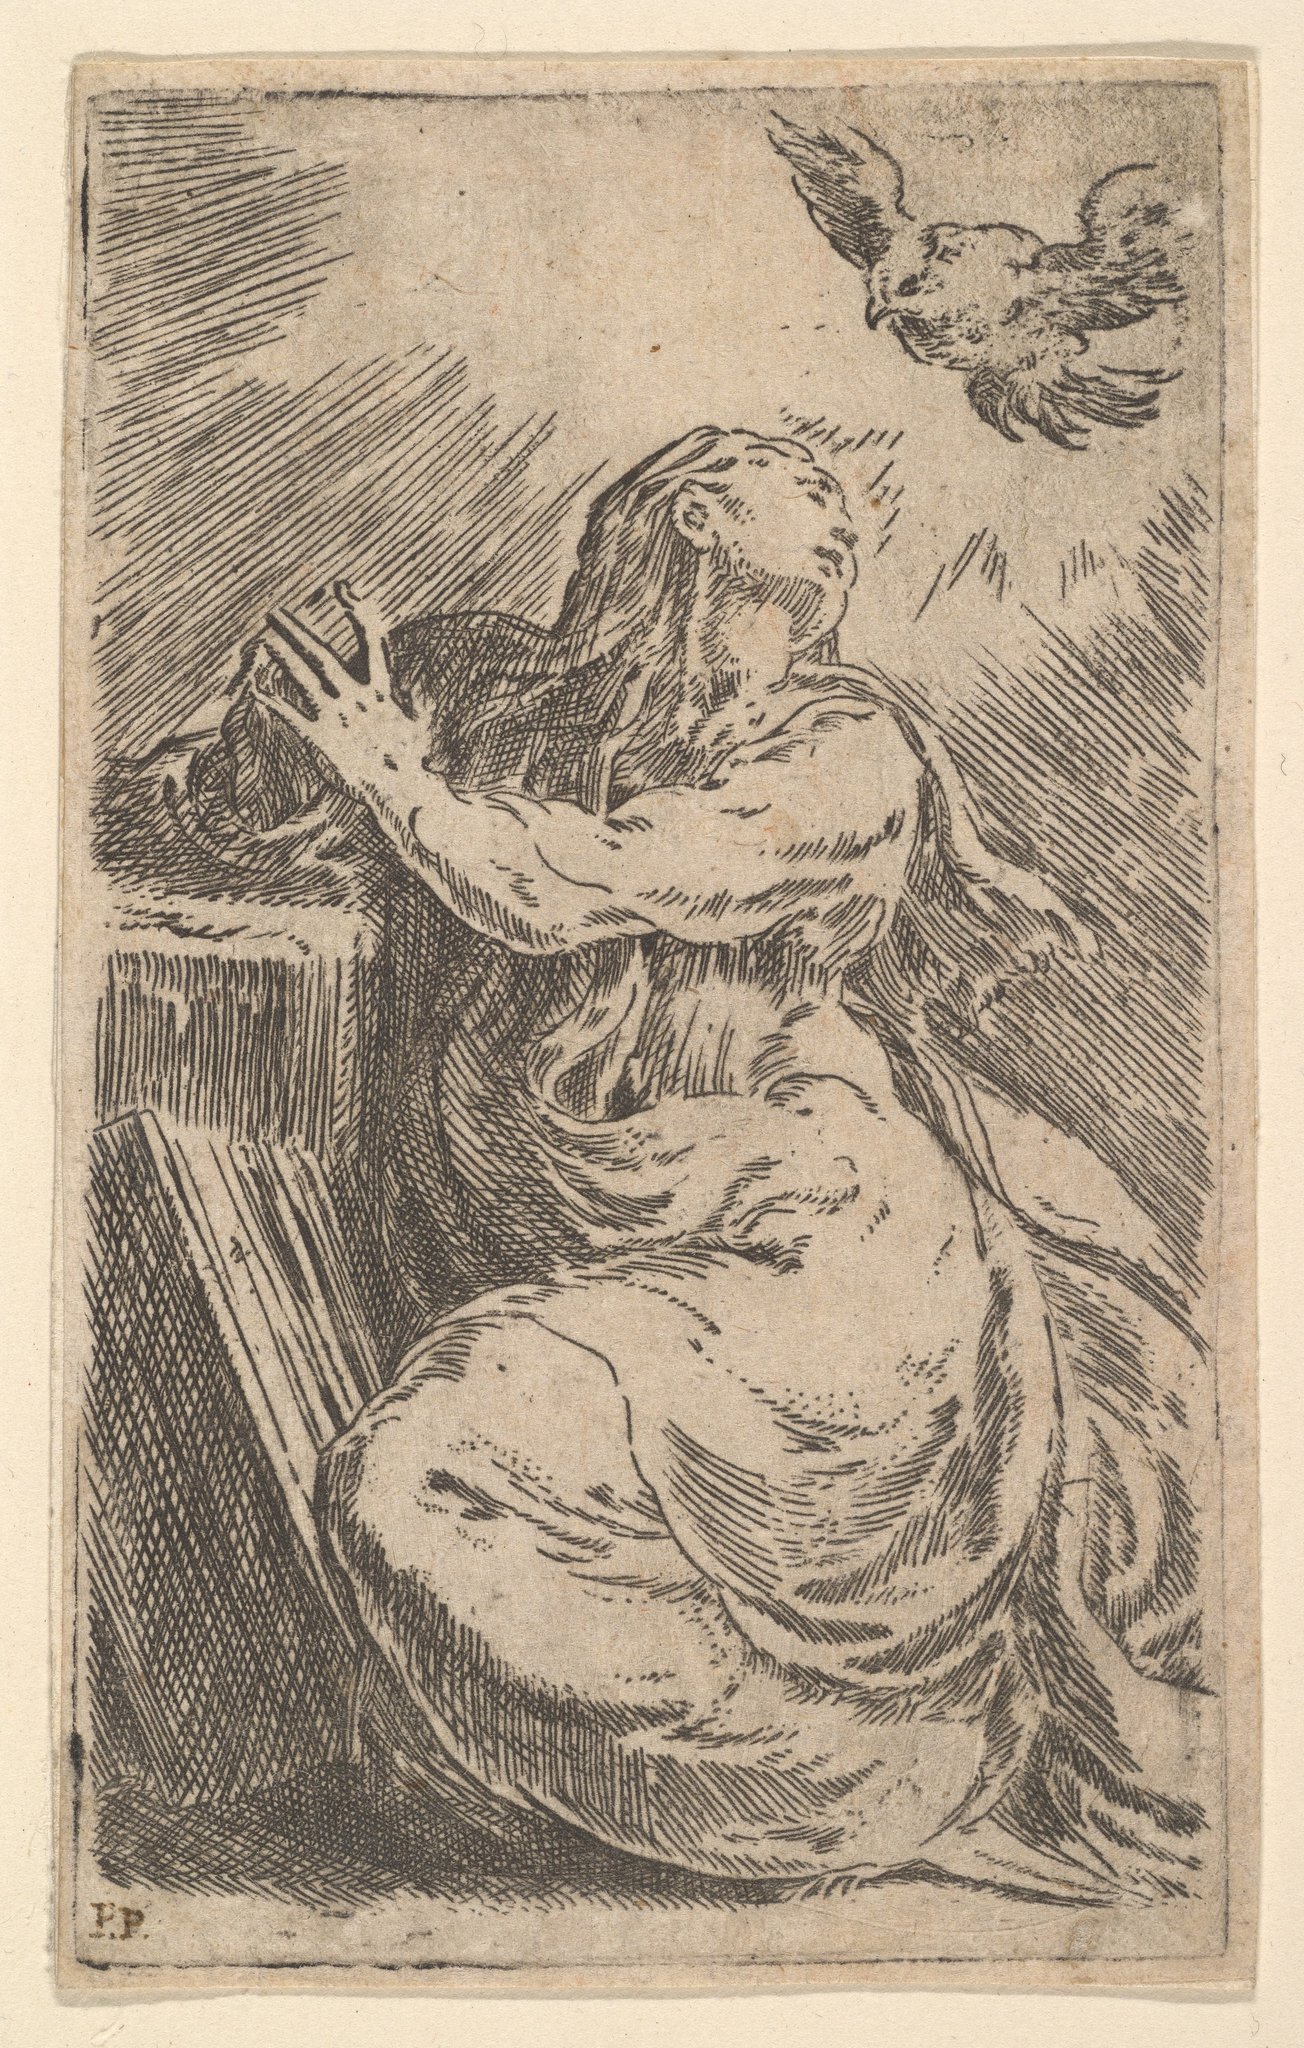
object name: print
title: The Annunciation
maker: parmigianino (girolamo francesco maria mazzola)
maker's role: artist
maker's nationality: italian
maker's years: 1503-1540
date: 1501-1533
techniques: etching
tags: birds,virgin mary,annunciation